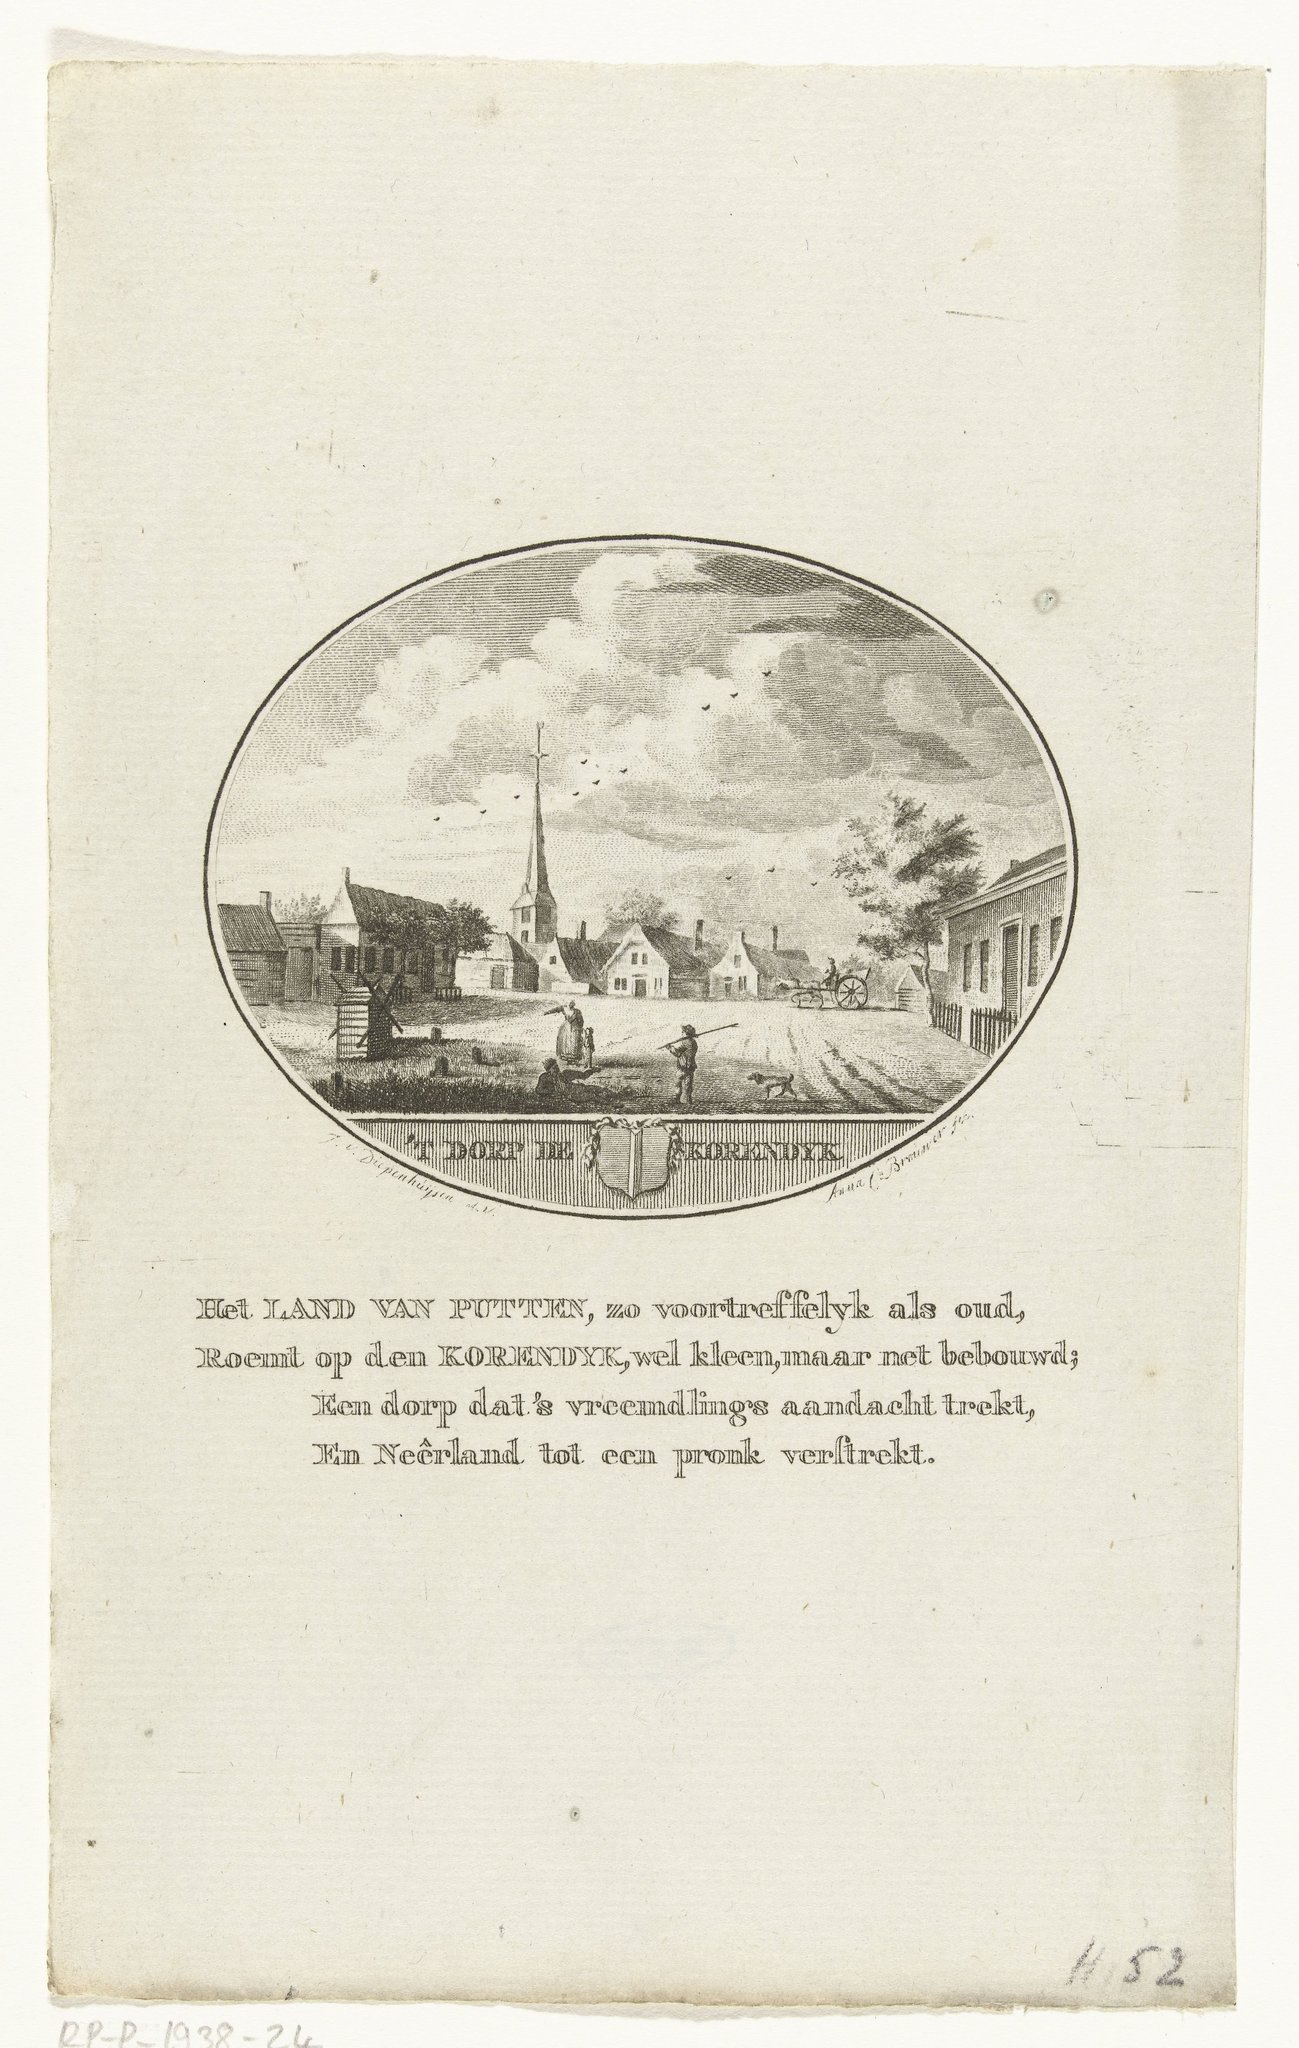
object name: book illustration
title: 't Dorp de Korendyk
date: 1791-1793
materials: paper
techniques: etching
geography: amsterdam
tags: city-view in general; 'veduta'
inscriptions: collector's mark: Lugt 2228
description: afkomstig uit: L. van Ollefen, De Nederlandsche stad- en dorp-beschrijver. Deel 1, Amsterdam: Hendrik Arend Banse, 1793.